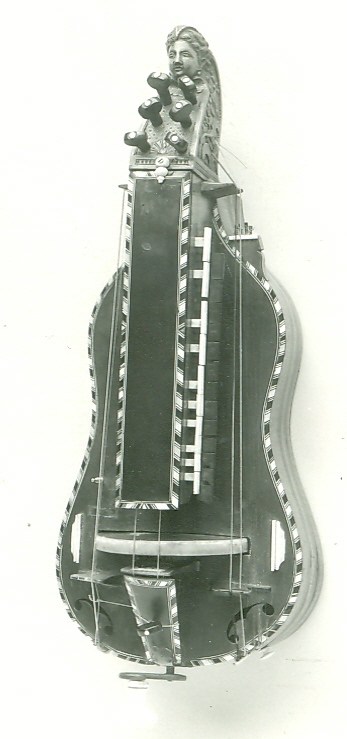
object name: vielle à roue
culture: french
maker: françois le jeune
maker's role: maker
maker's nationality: french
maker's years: 1722-1784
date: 1760-1780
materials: wood, ivory, mother of pearl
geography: france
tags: heads